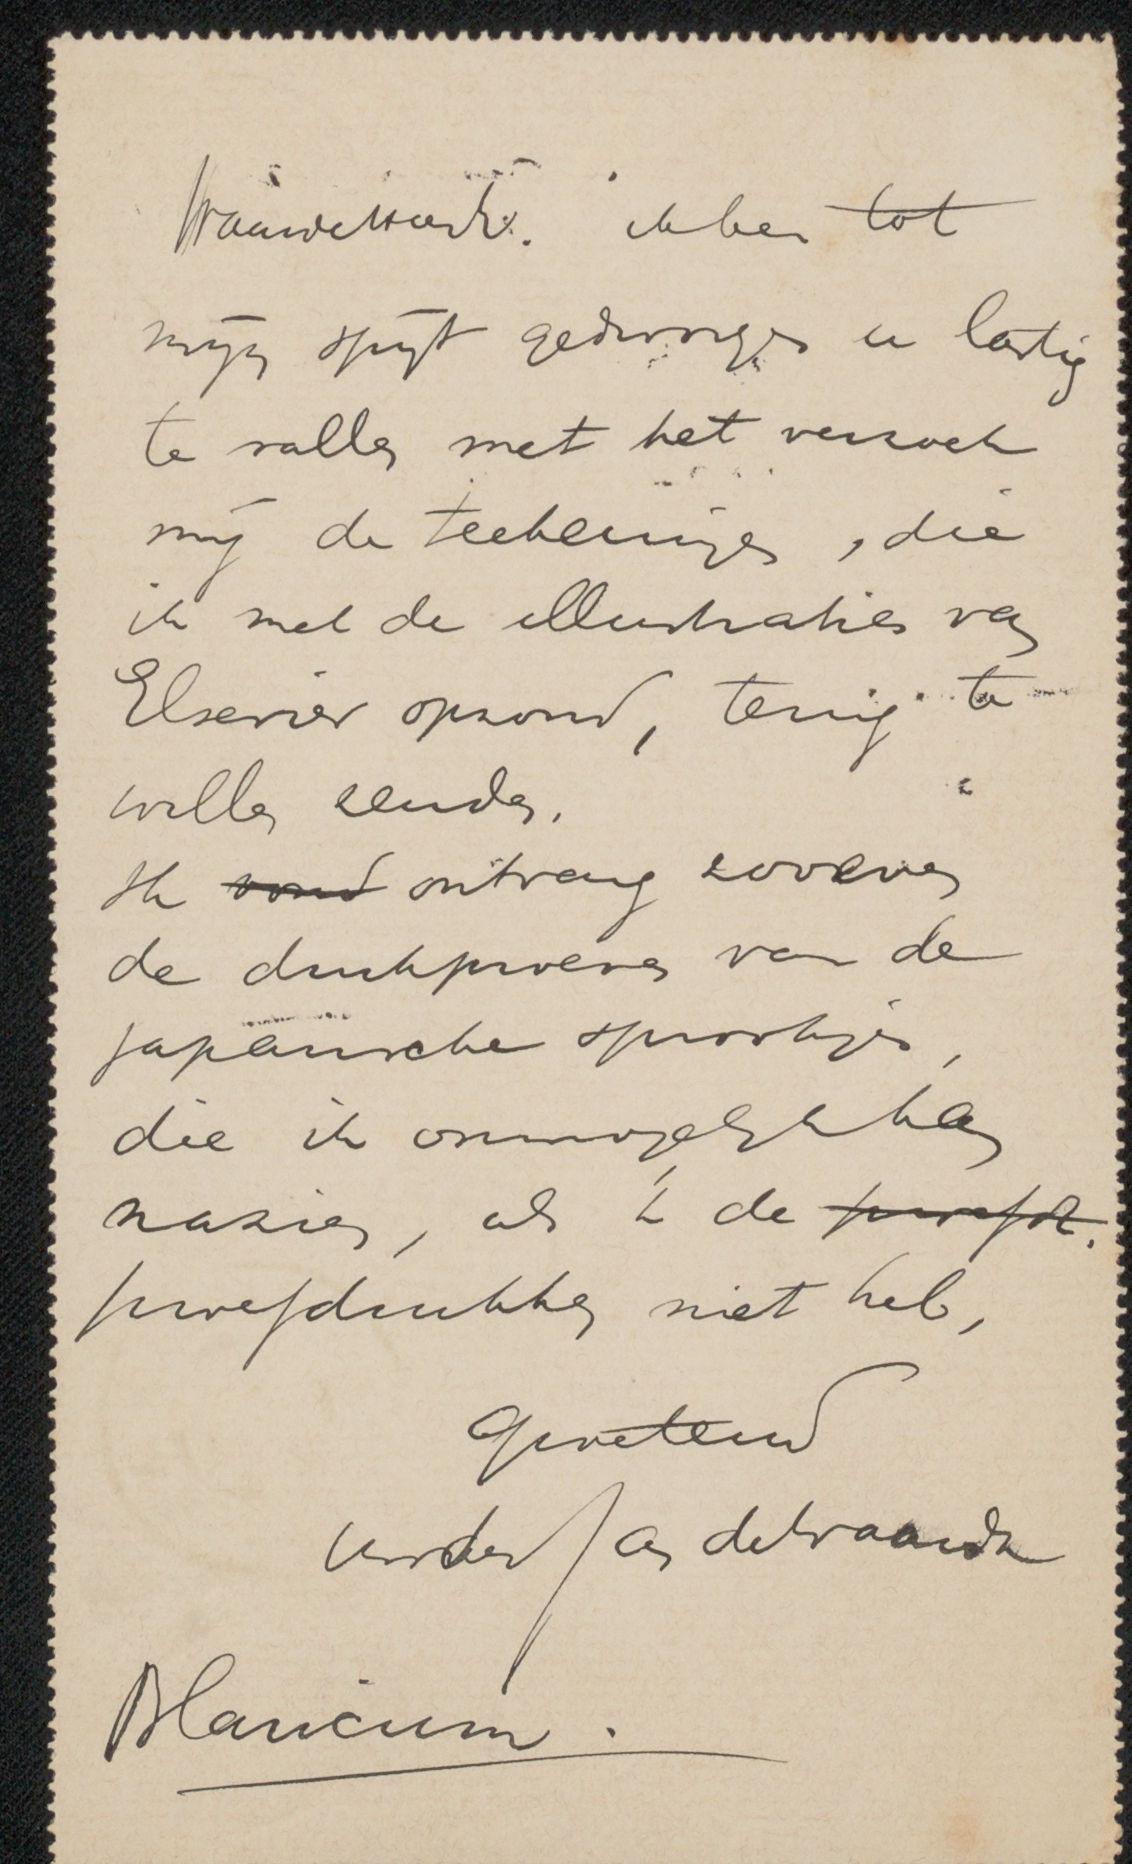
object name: letter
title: Brief aan Philip Zilcken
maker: jan de waardt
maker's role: draughtsman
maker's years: 1871-1909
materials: ink, paper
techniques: pen, writing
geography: blaricum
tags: painter, draughtsman, philip zilcken, drawing, illustration ~ printed matter, book, printed matter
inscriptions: collector's mark: ‘RPK’